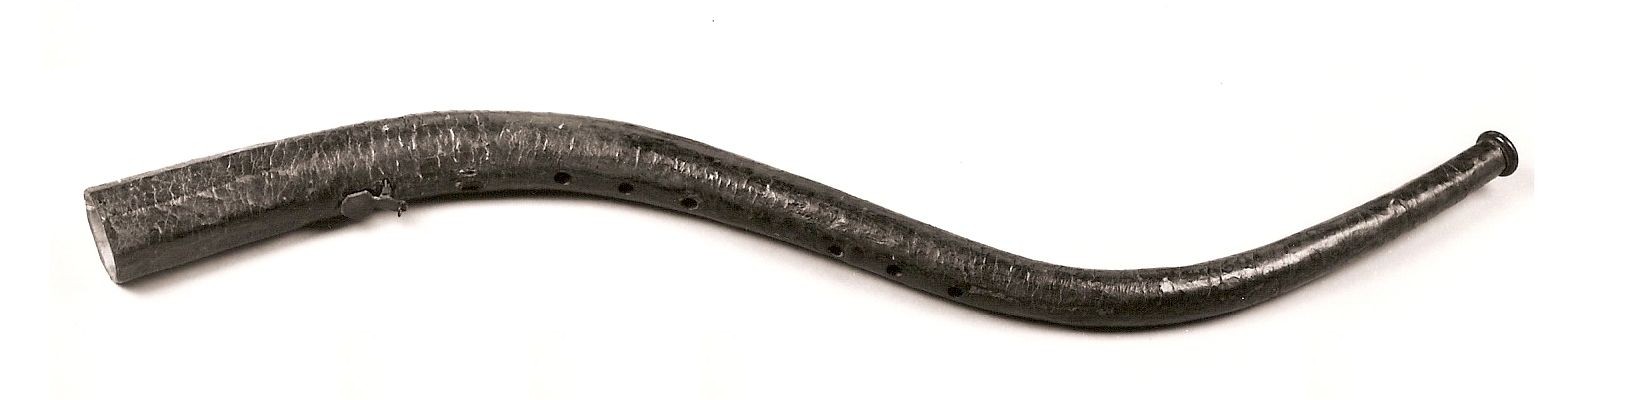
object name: tenor cornetto in d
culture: french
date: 1601-1700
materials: leather, metal, wood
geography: france